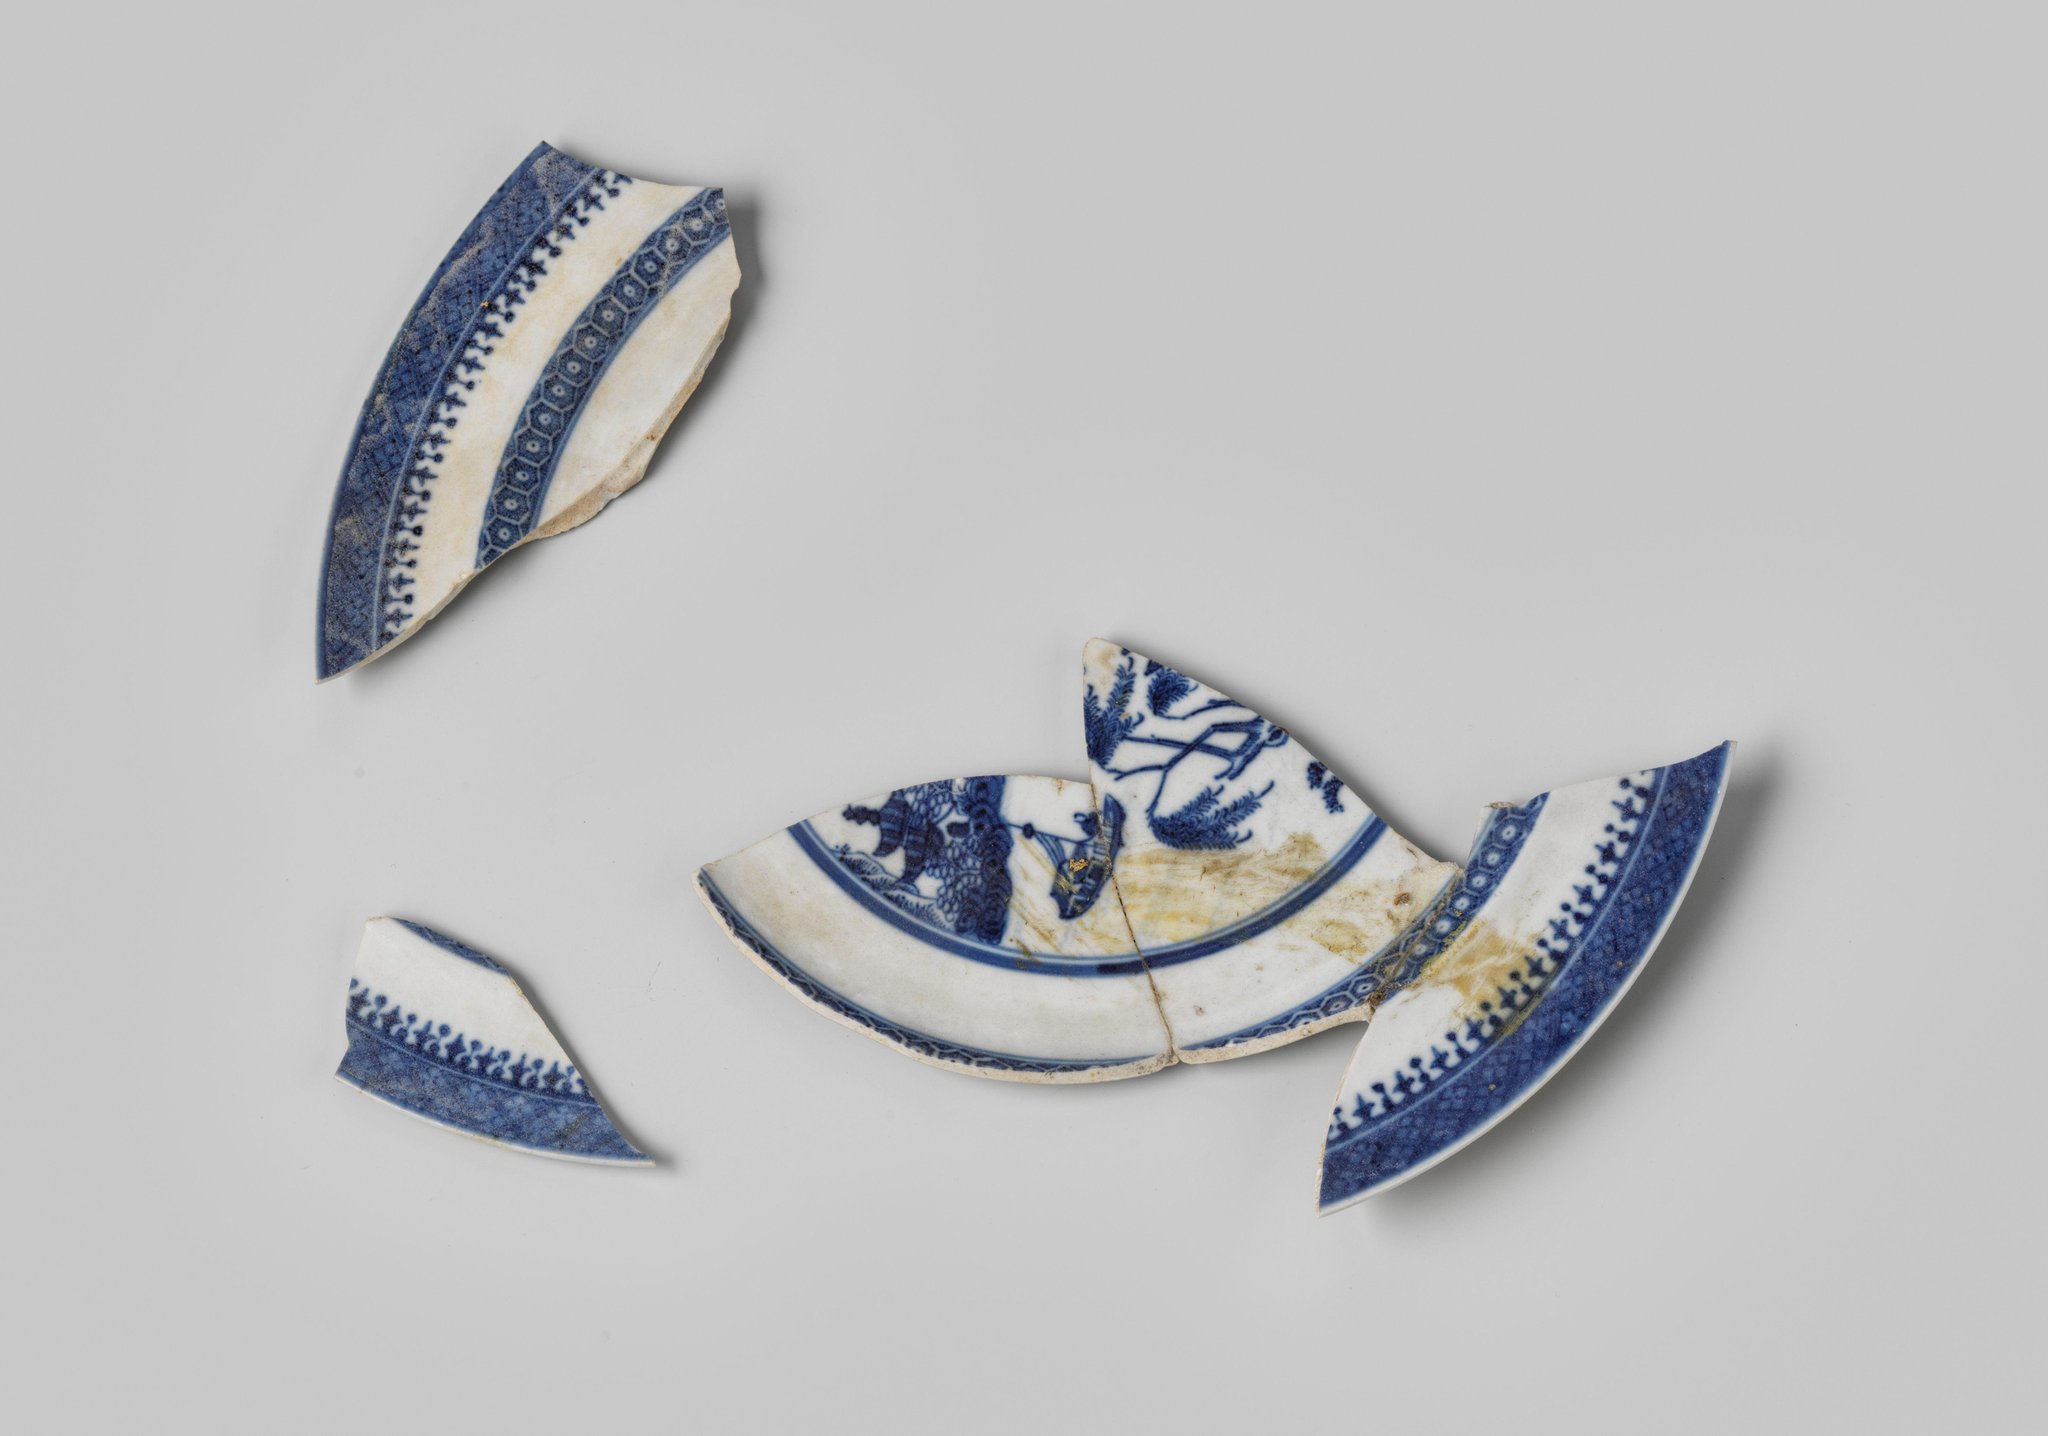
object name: plate dish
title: Drie porseleinen scherven van verschillende borden, gevonden bij V.O.C.-schip Witte Leeuw, mogelijk afkomstig van Zeelelie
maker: Anonymous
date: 1775-1800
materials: porcelain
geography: jingdezhen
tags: verenigde oostindische compagnie, sint-helena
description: Drie porseleinen scherven, waarvan één bestaat uit drie aan elkaar gelijmde fragmenten, van verschillende borden gemaakt voor export naar Anglo-Saxische landen, Nanking-ceramiek bord. In drie stukken, waarvan één uit twee vastgelijmde fragmenten bestaat. Dit object is 18e-eeuws en kan dus niet van de vracht van de Witte Leeuw zijn. Onduidelijk is of het object van de site komt of dat het later is vermengd, mogelijk met materiaal van de Zeelelie.